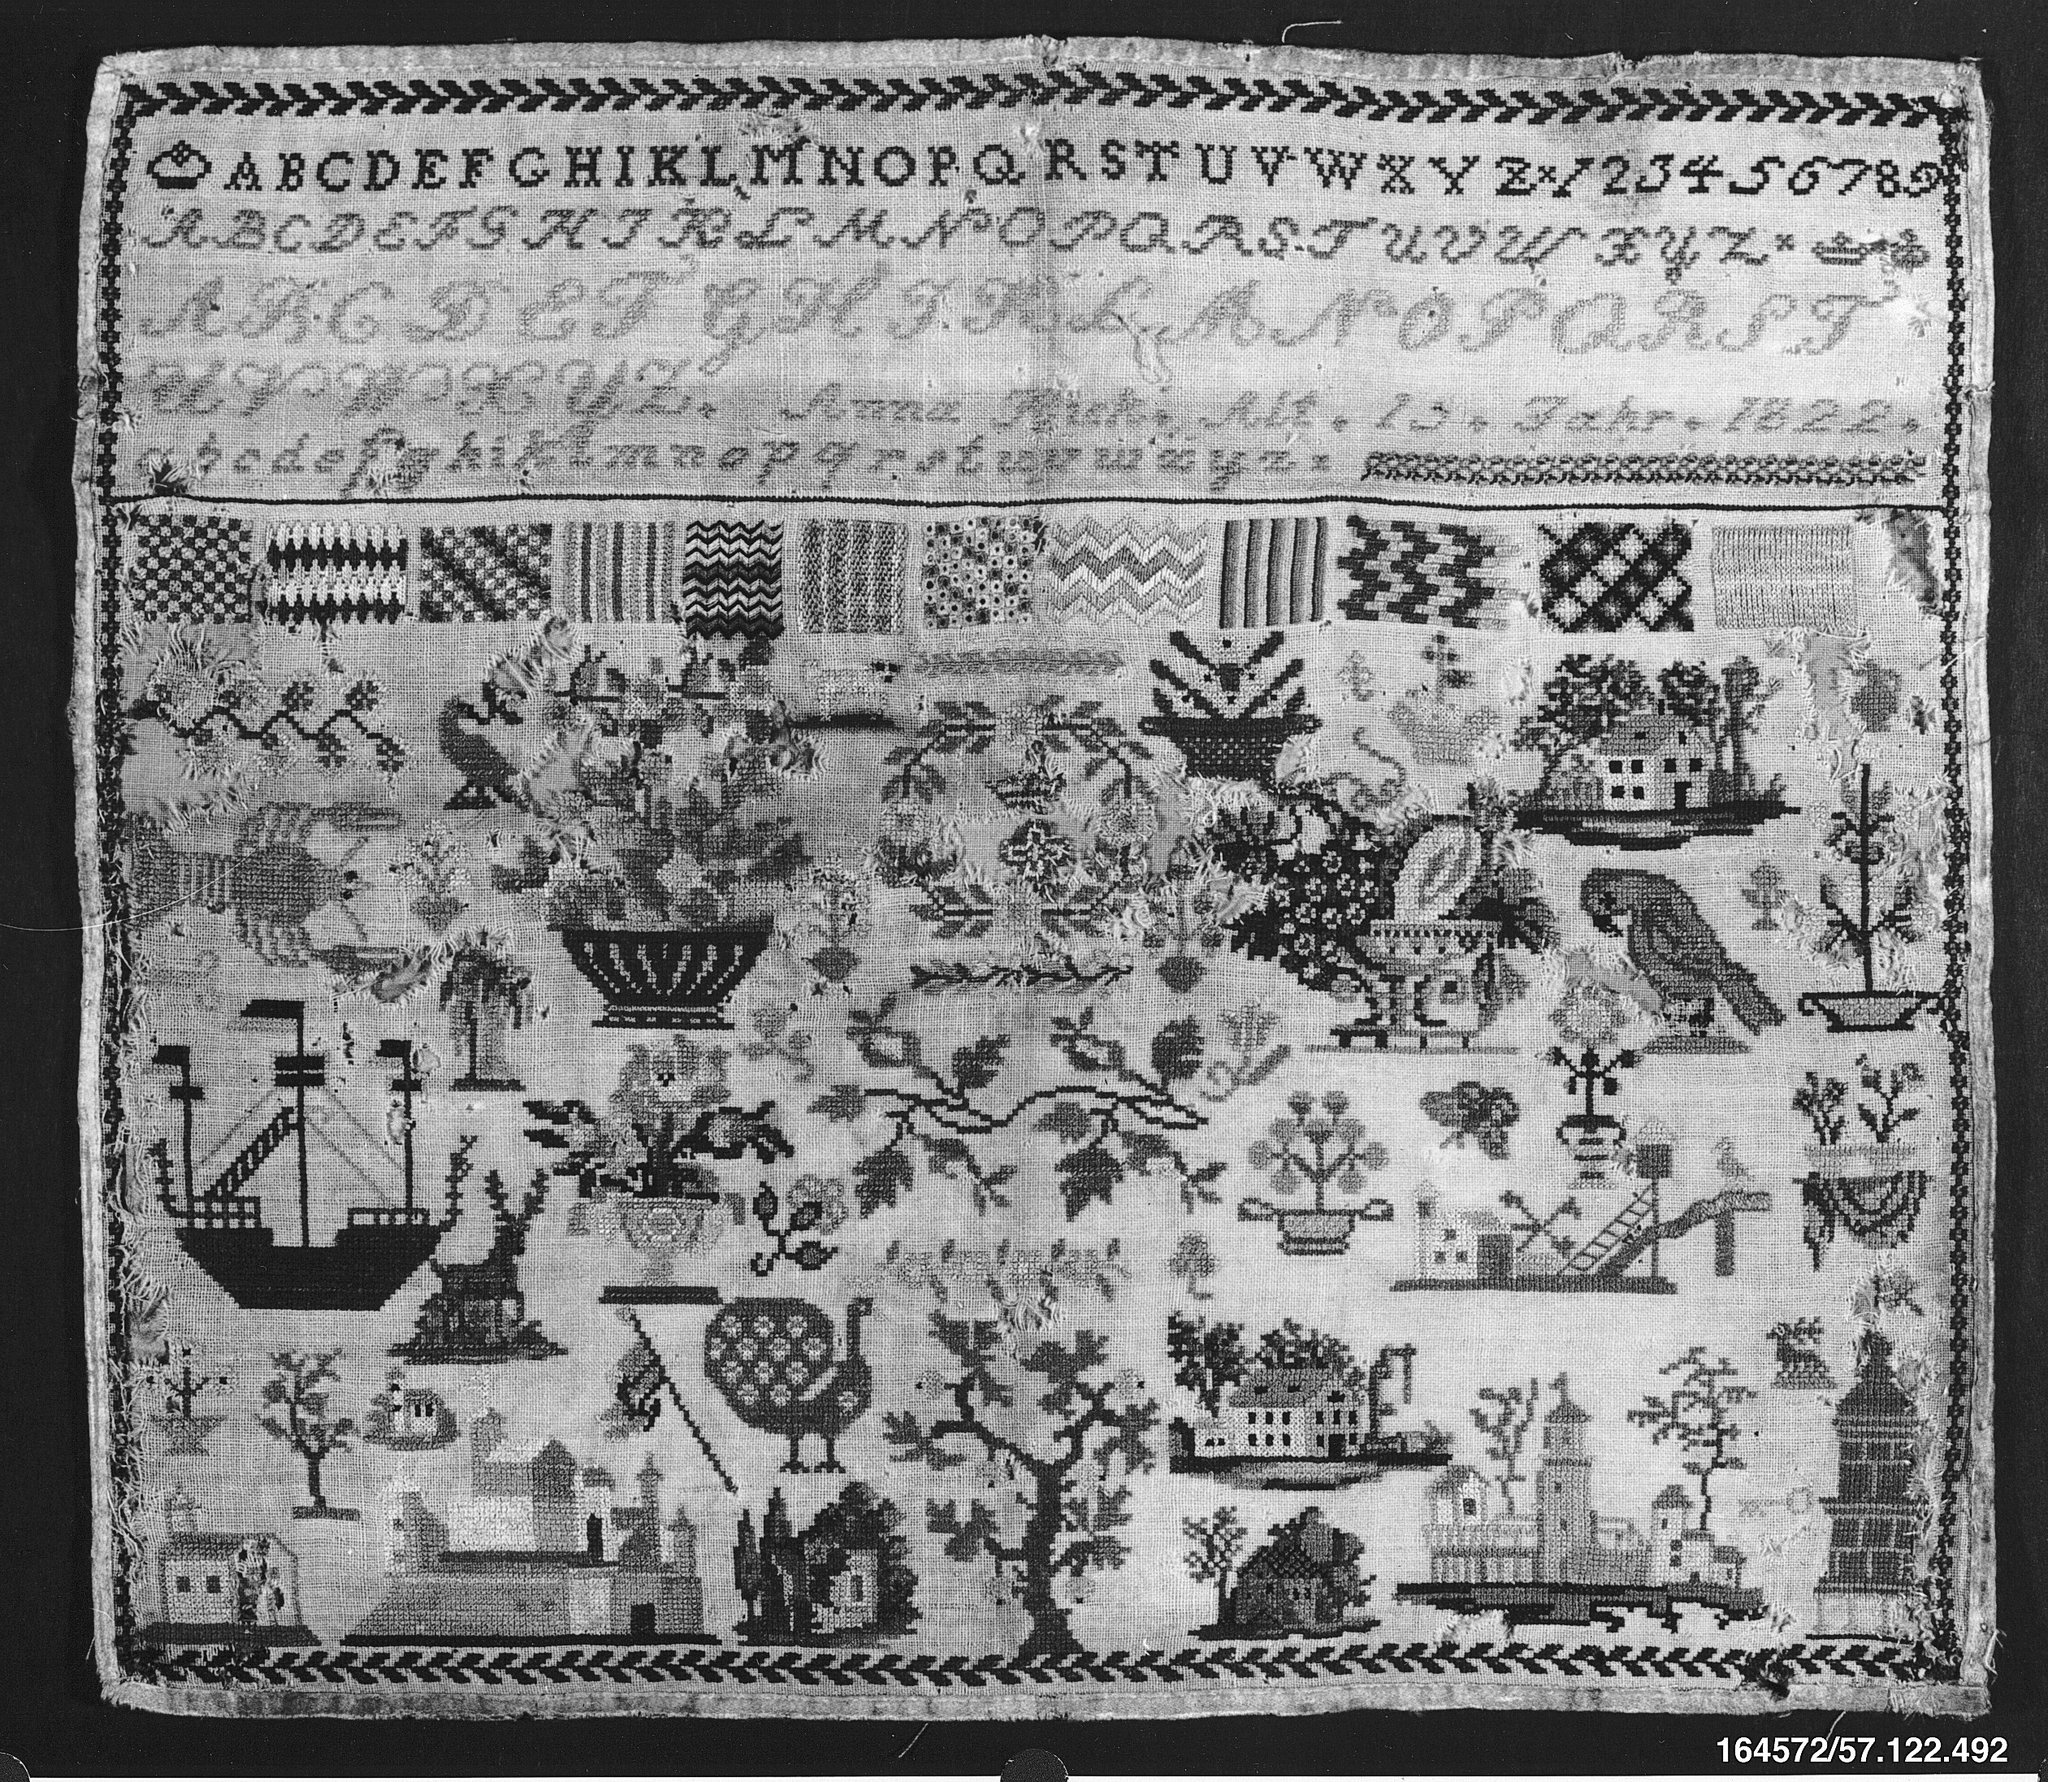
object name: sampler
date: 1822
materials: canvas, silk, wool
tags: birds,ships